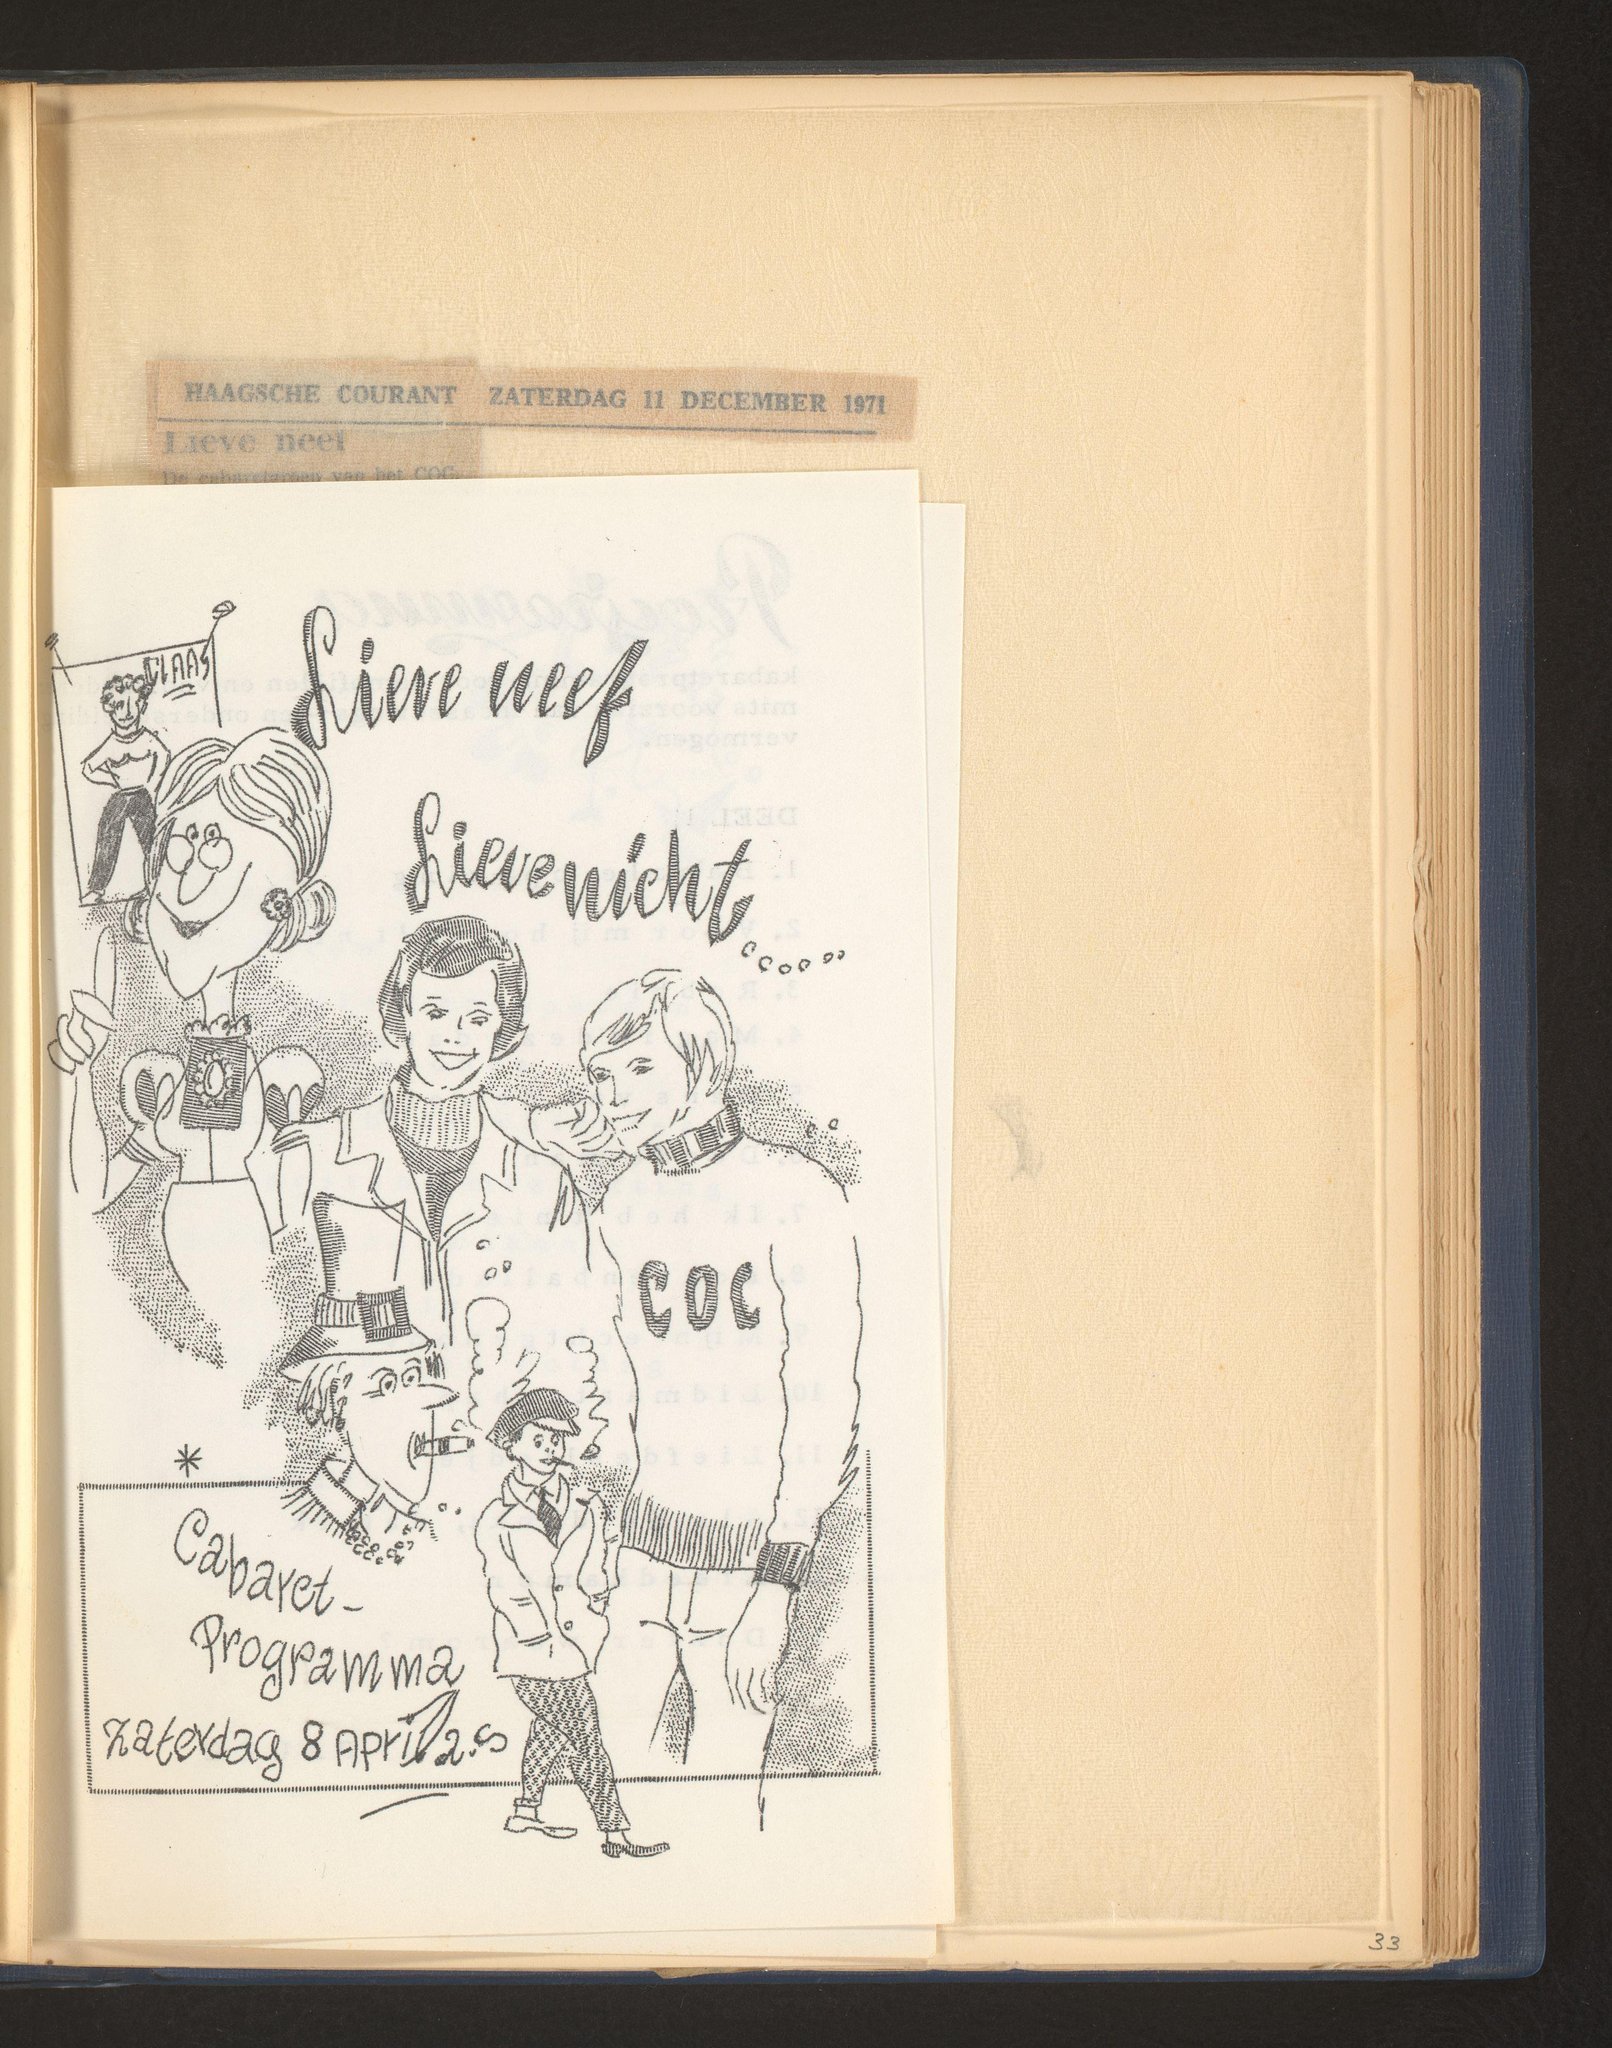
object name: programma, programmaboekje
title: Programma voor de cabaretvoorstelling 'Lieve Neef - Lieve Nicht' verzorgd door leden van het COC afdeling Den Haag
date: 1972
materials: cardboard, paper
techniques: printed materials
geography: the hague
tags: the hague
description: Tussen de albumbladen geplakt (dubbelgevouwen) programma voor een uitvoering op 8 april 1972 van het cabaretvoorstelling 'Lieve Neef - Lieve Nicht', verzorgd door leden van het COC afdeling Den Haag, in het gebouw van de COC te Rotterdam. Onderdeel van het fotoalbum van cabaretvoorstellingen COC 1968-1974, afdeling Den Haag.